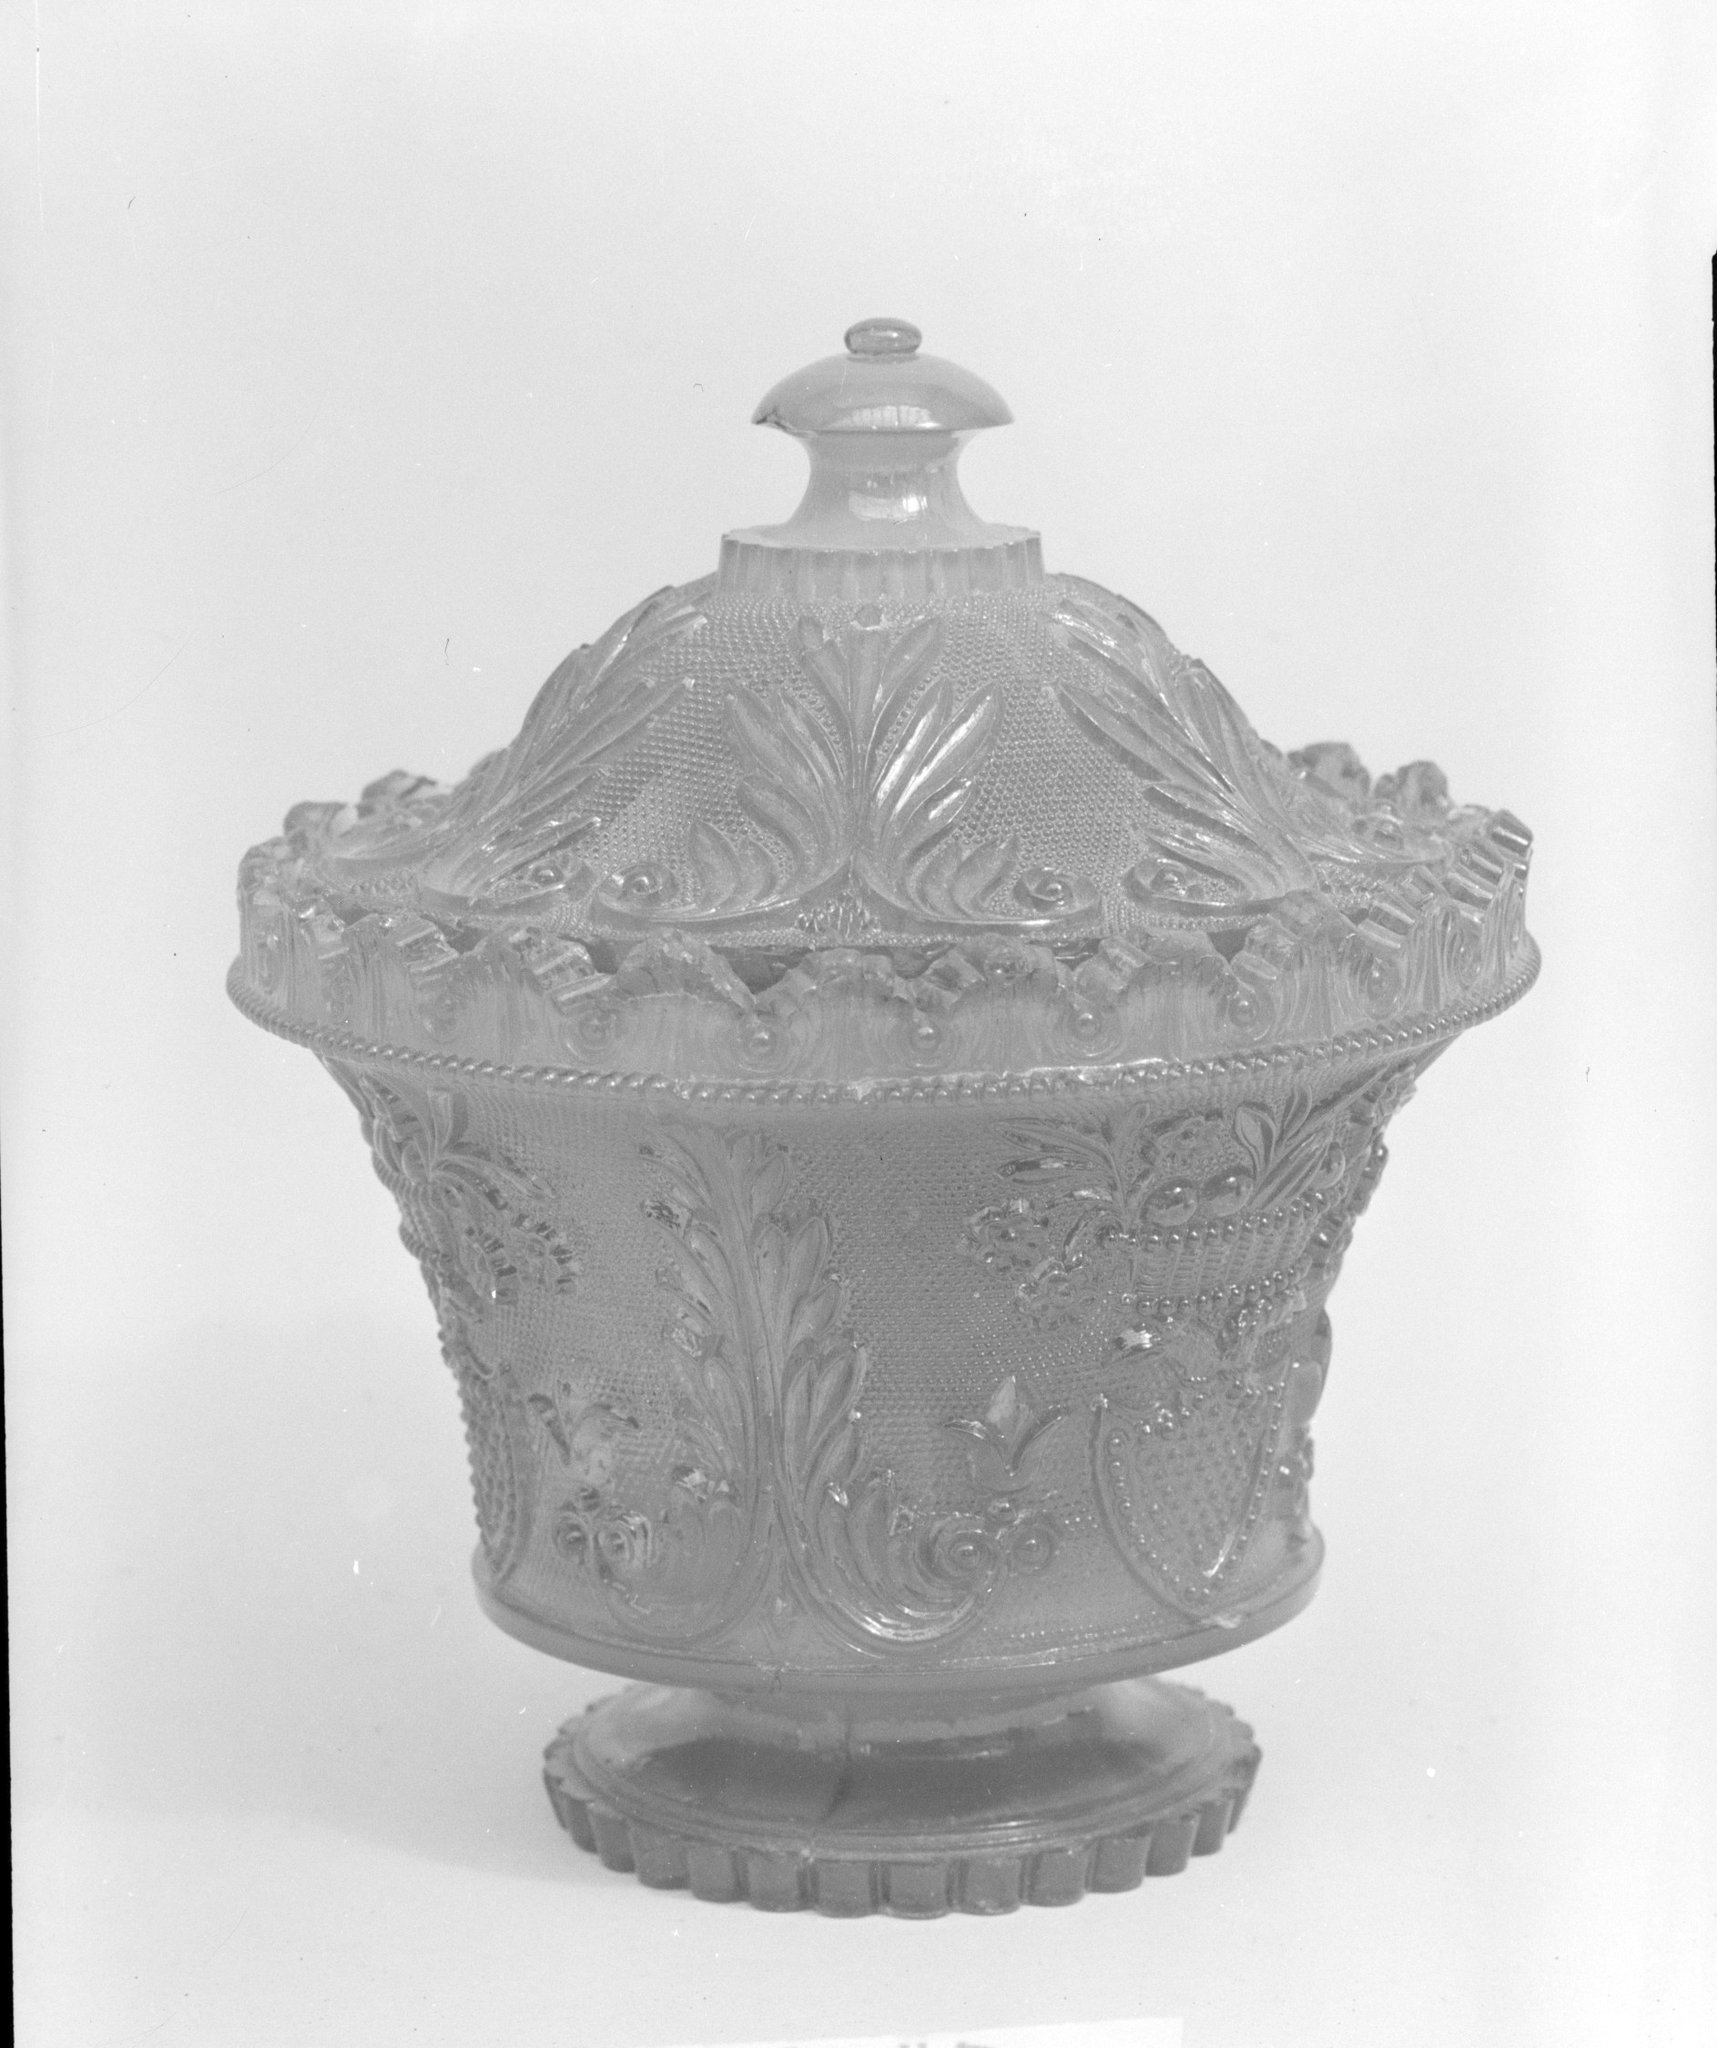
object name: sugar bowl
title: Covered Sugar Bowl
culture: american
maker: providence flint glass works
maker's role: maker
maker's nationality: american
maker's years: 1830-1833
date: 1830-1833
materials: glass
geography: united states